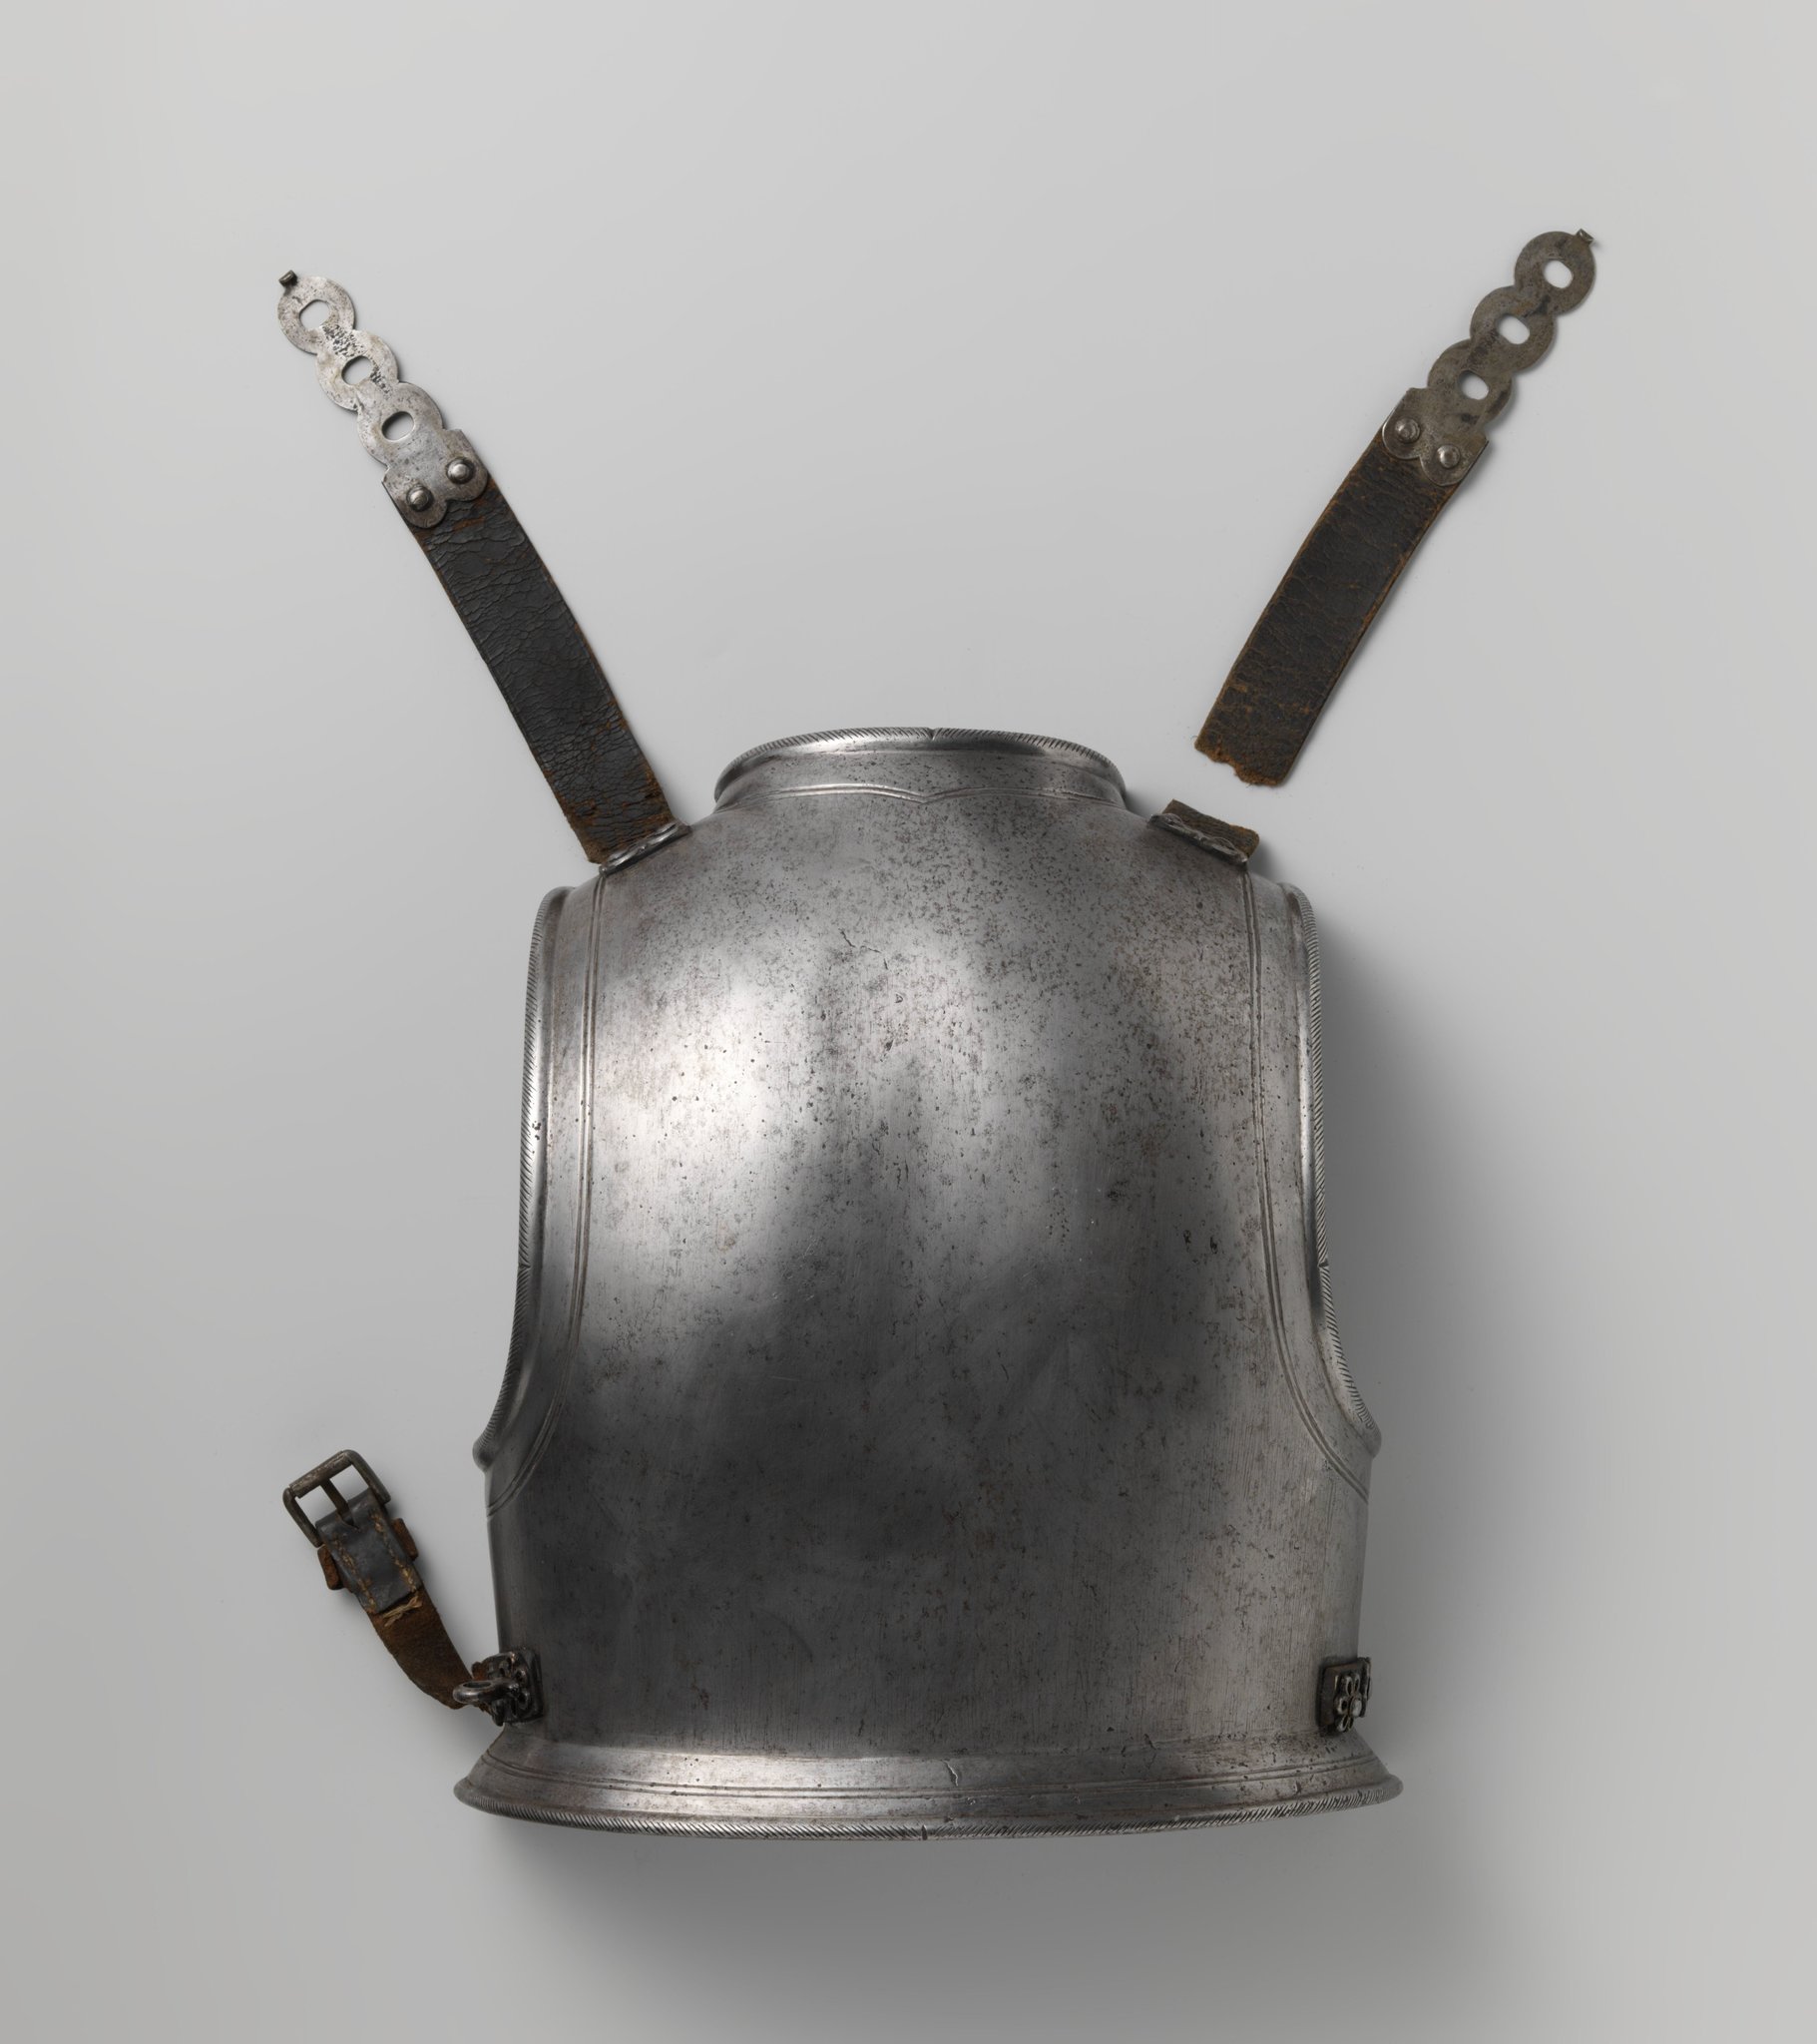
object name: backplate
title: Rugplaat van een harquebusiers harnas voor een jongeman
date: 1610-1620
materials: iron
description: Rugplaat van harquebusiers harnas voor een jongeman. Zie beschrijving borststuk